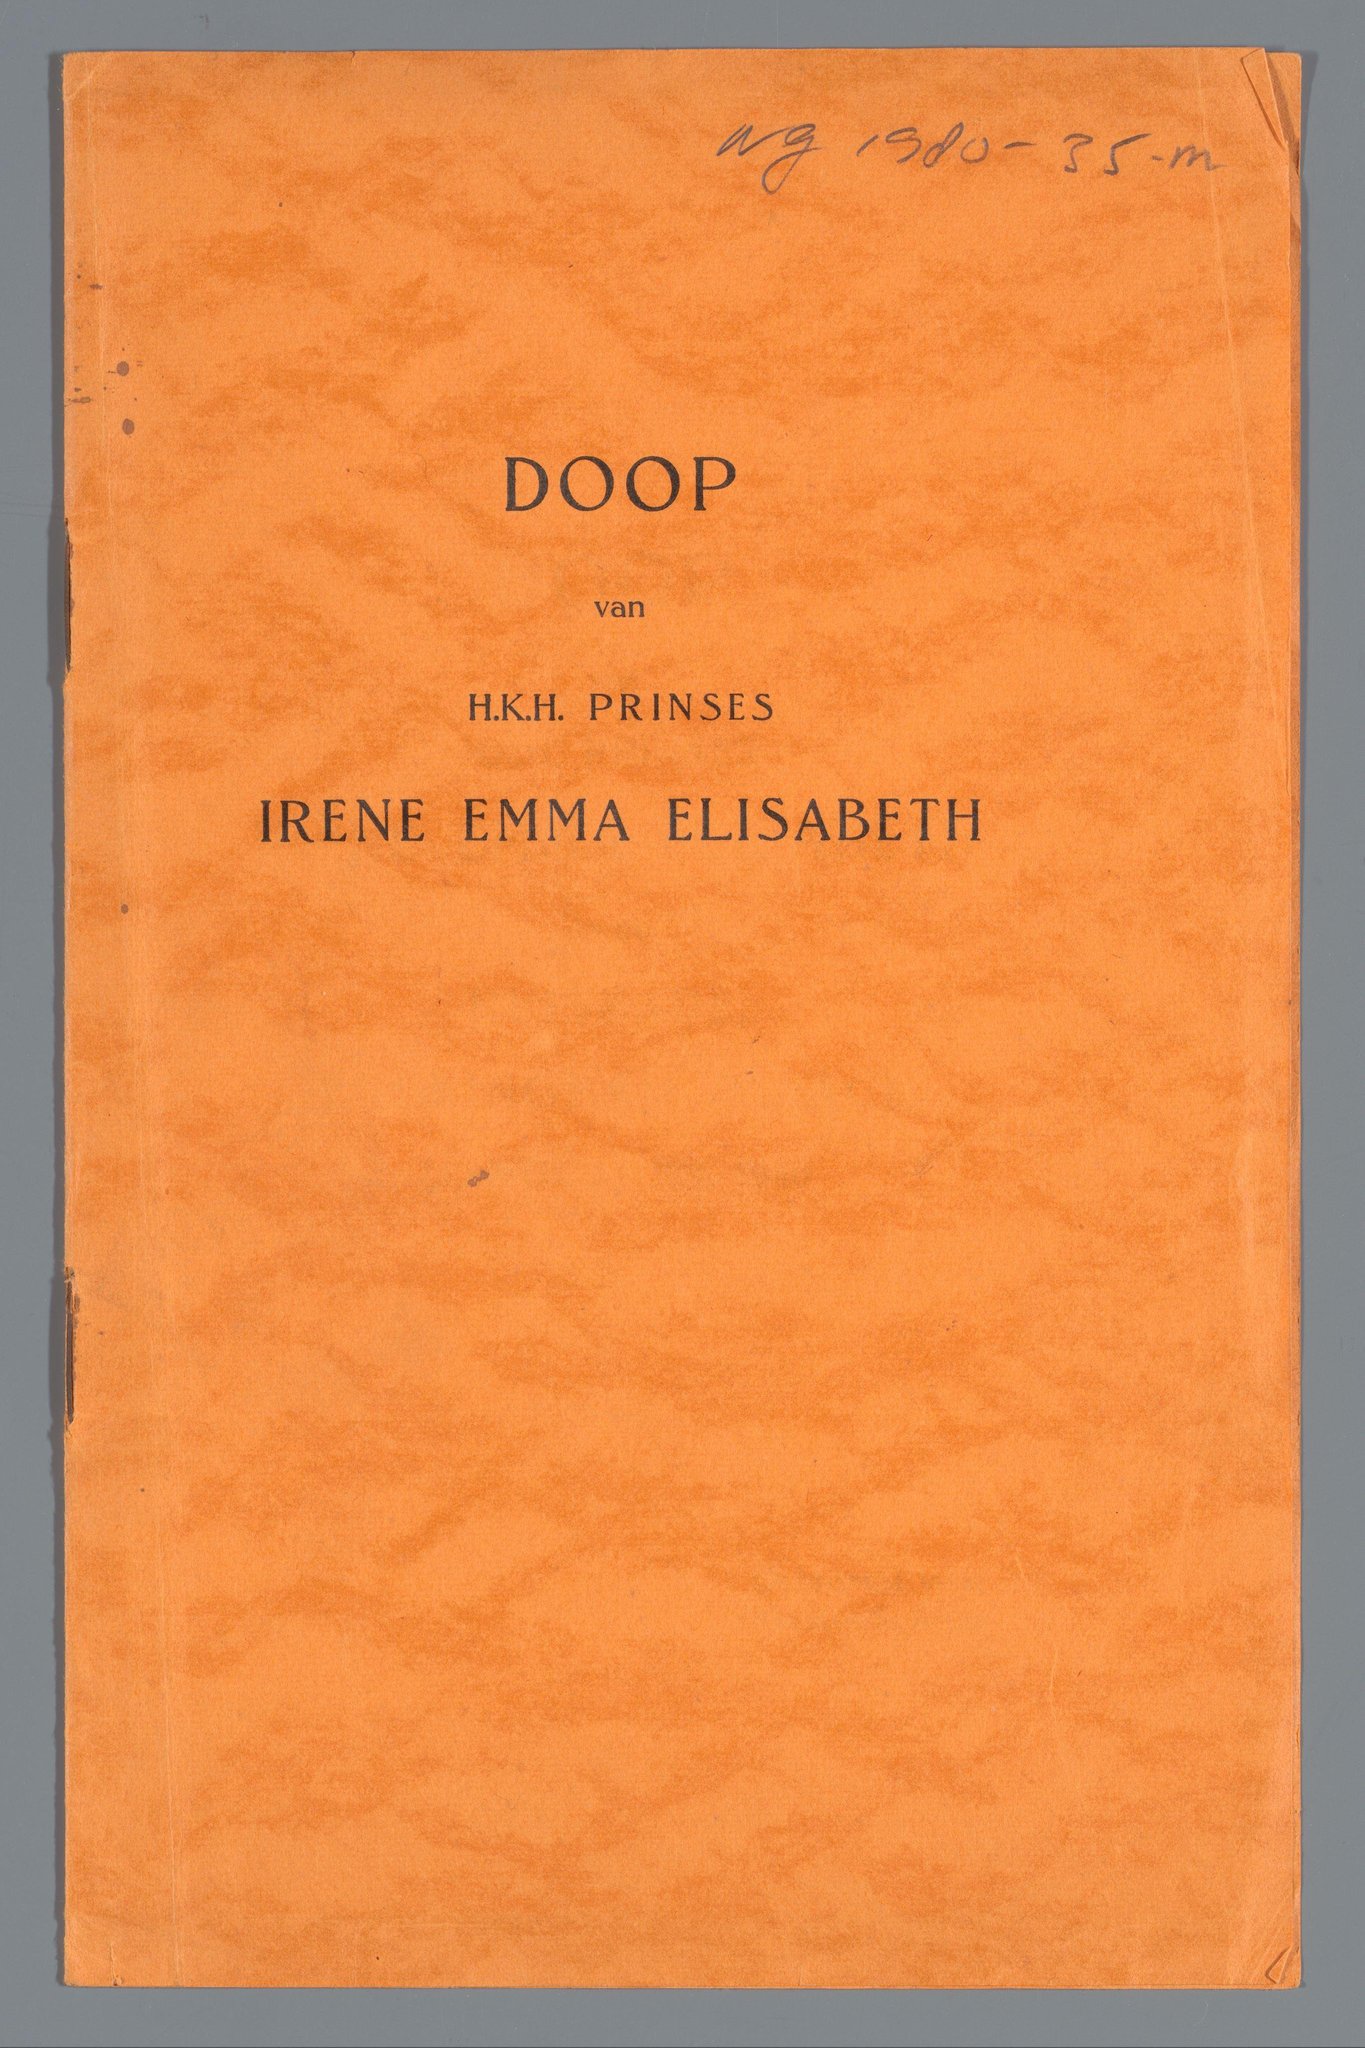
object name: book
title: Doop van HKH Prinses Irene Emma Elisabeth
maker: ds jan van dorp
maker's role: schrijver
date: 1940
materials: paper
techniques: printing, stapling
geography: london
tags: london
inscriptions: date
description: Boekje in oranje omslag. Gedateerd; omslag: 31 mei 1940.